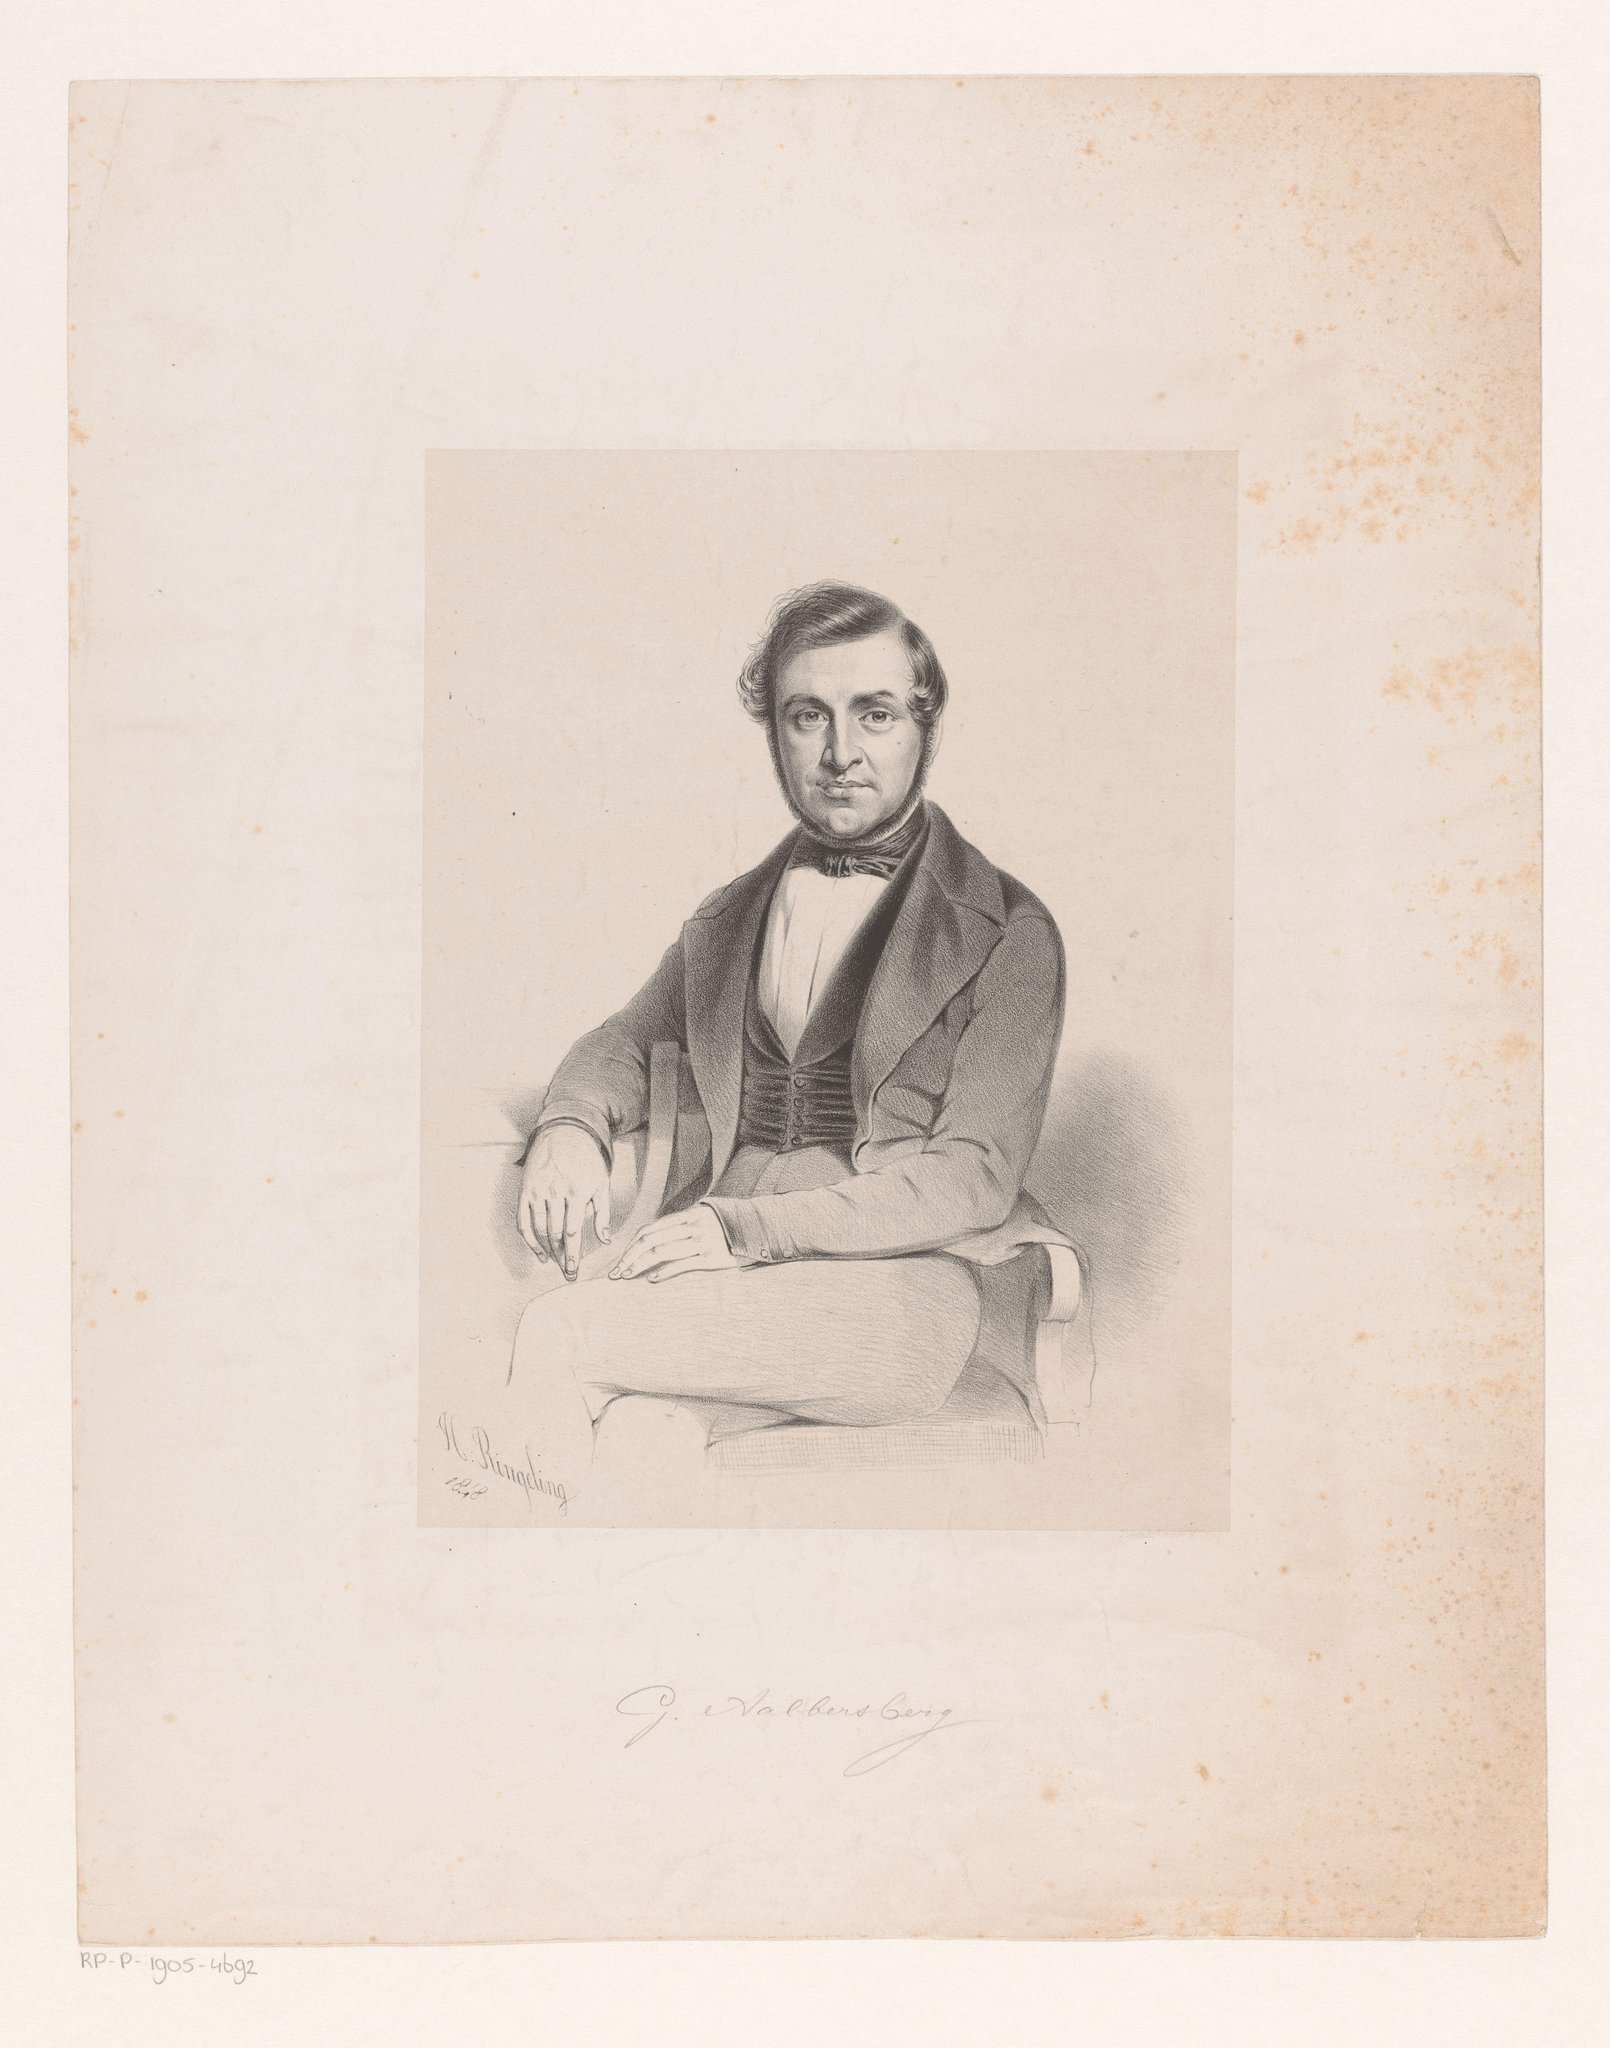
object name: print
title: Portret van Gerardus Aalbersberg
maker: pieter willem marinus trap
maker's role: print maker, printer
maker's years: 1821-1905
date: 1848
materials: paper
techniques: lithograph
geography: leiden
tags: historical persons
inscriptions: collector's mark: Lugt 2228